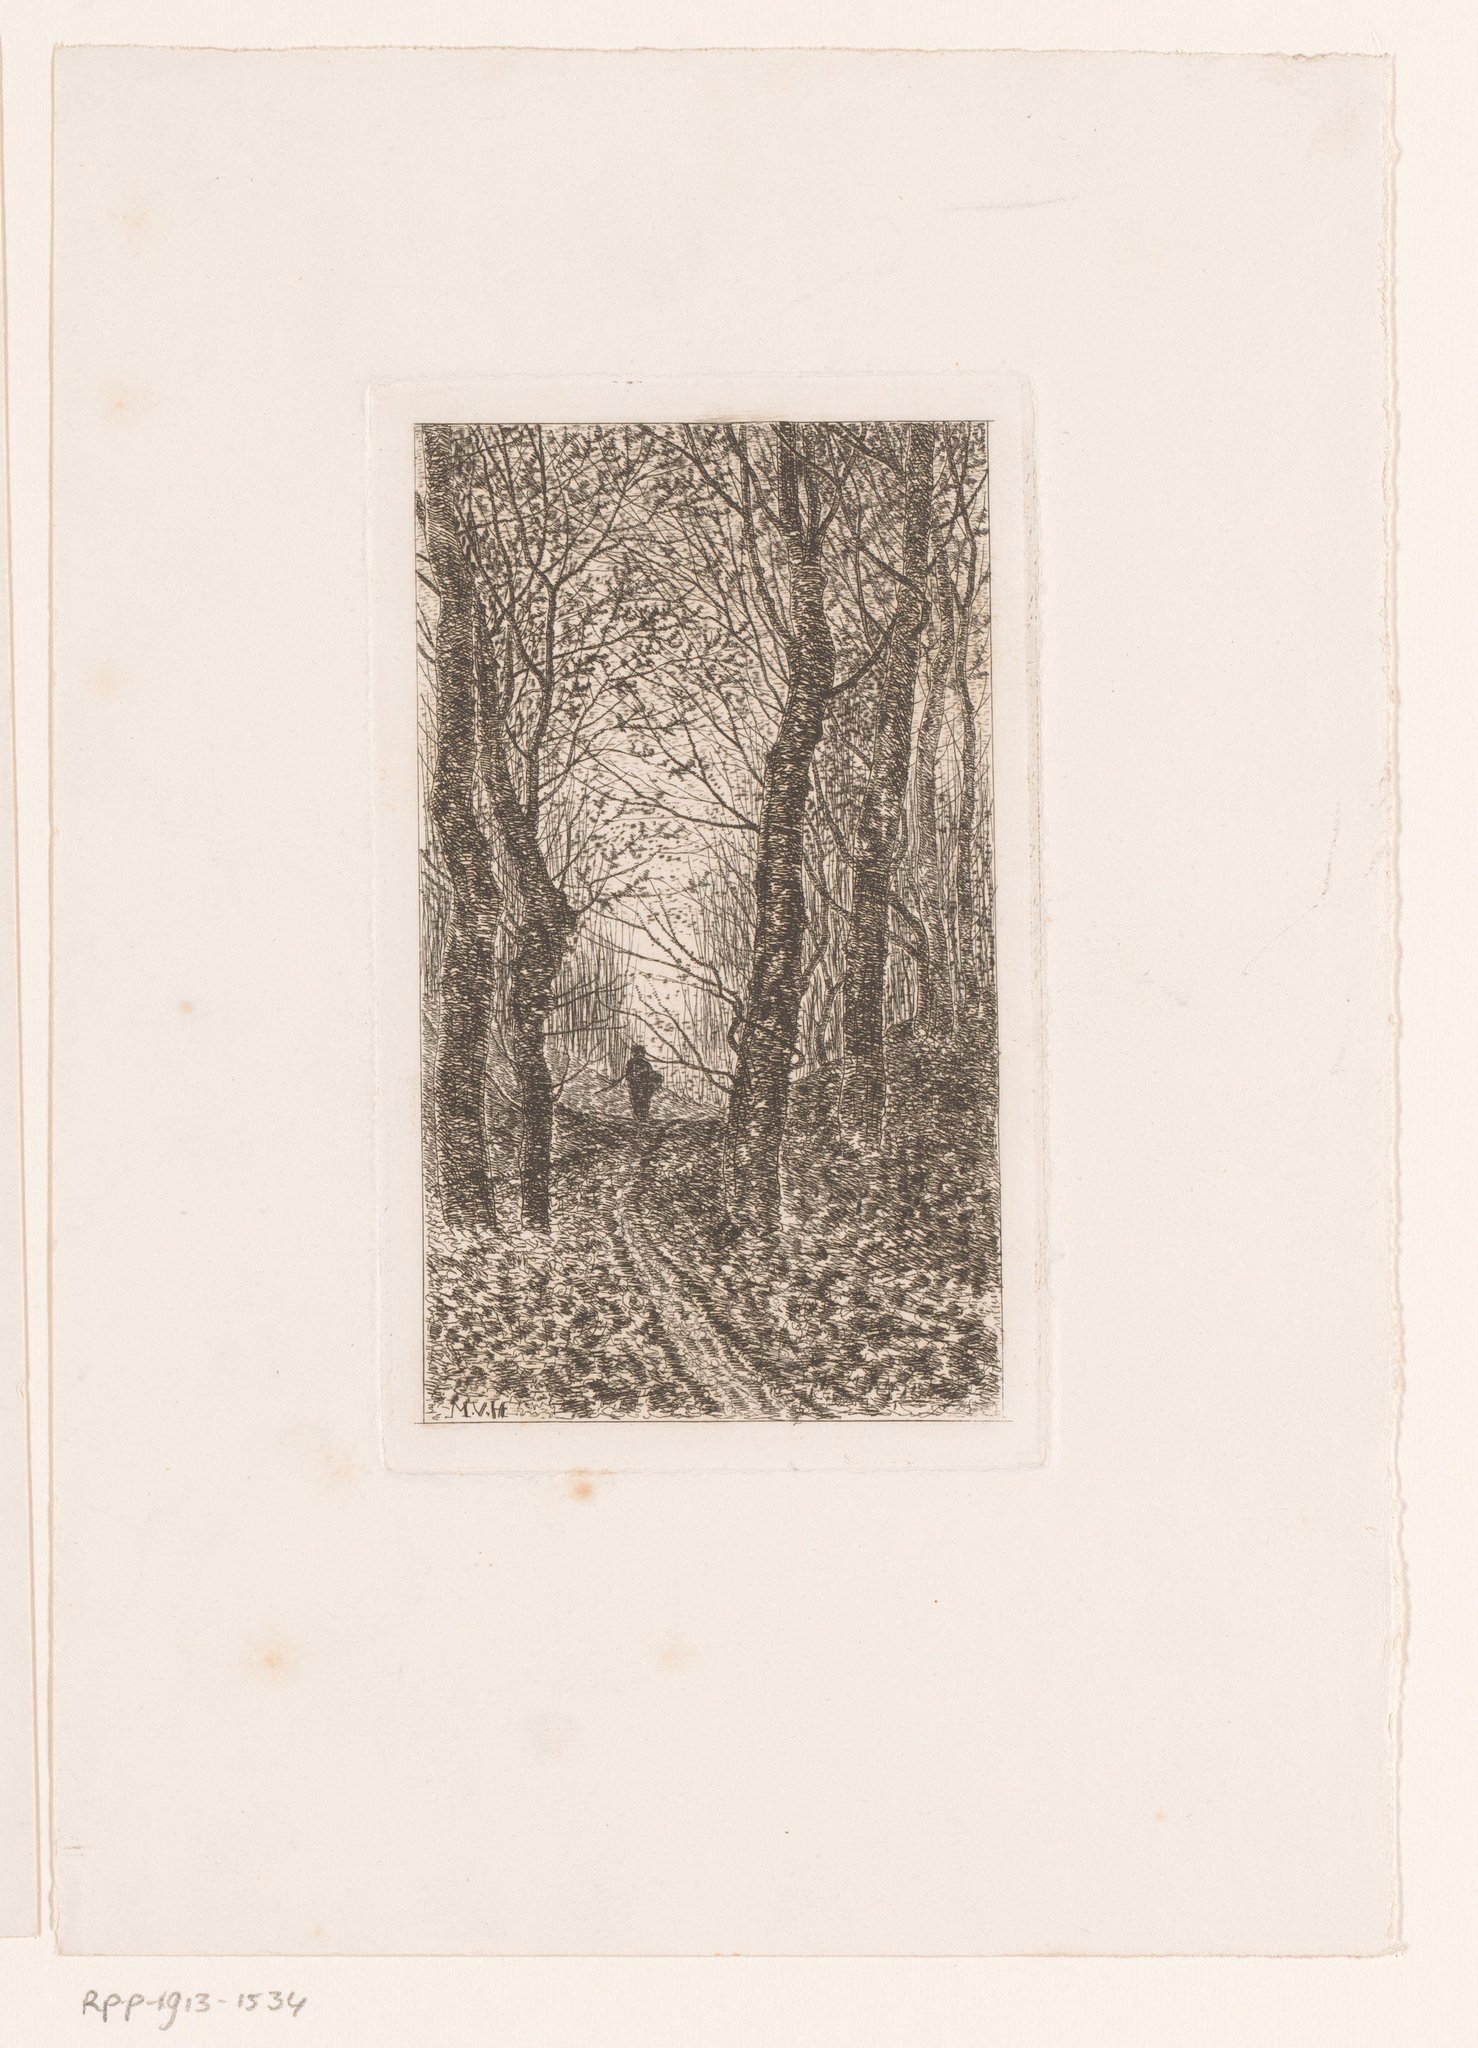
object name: print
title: Heuvelachtige bosweg met figuur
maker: h. van meerbeeck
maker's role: print maker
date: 1850-1913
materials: paper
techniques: etching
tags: low hill country, forest path or lane (+ landscape with figures, staffage)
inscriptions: collector's mark: Lugt 2228